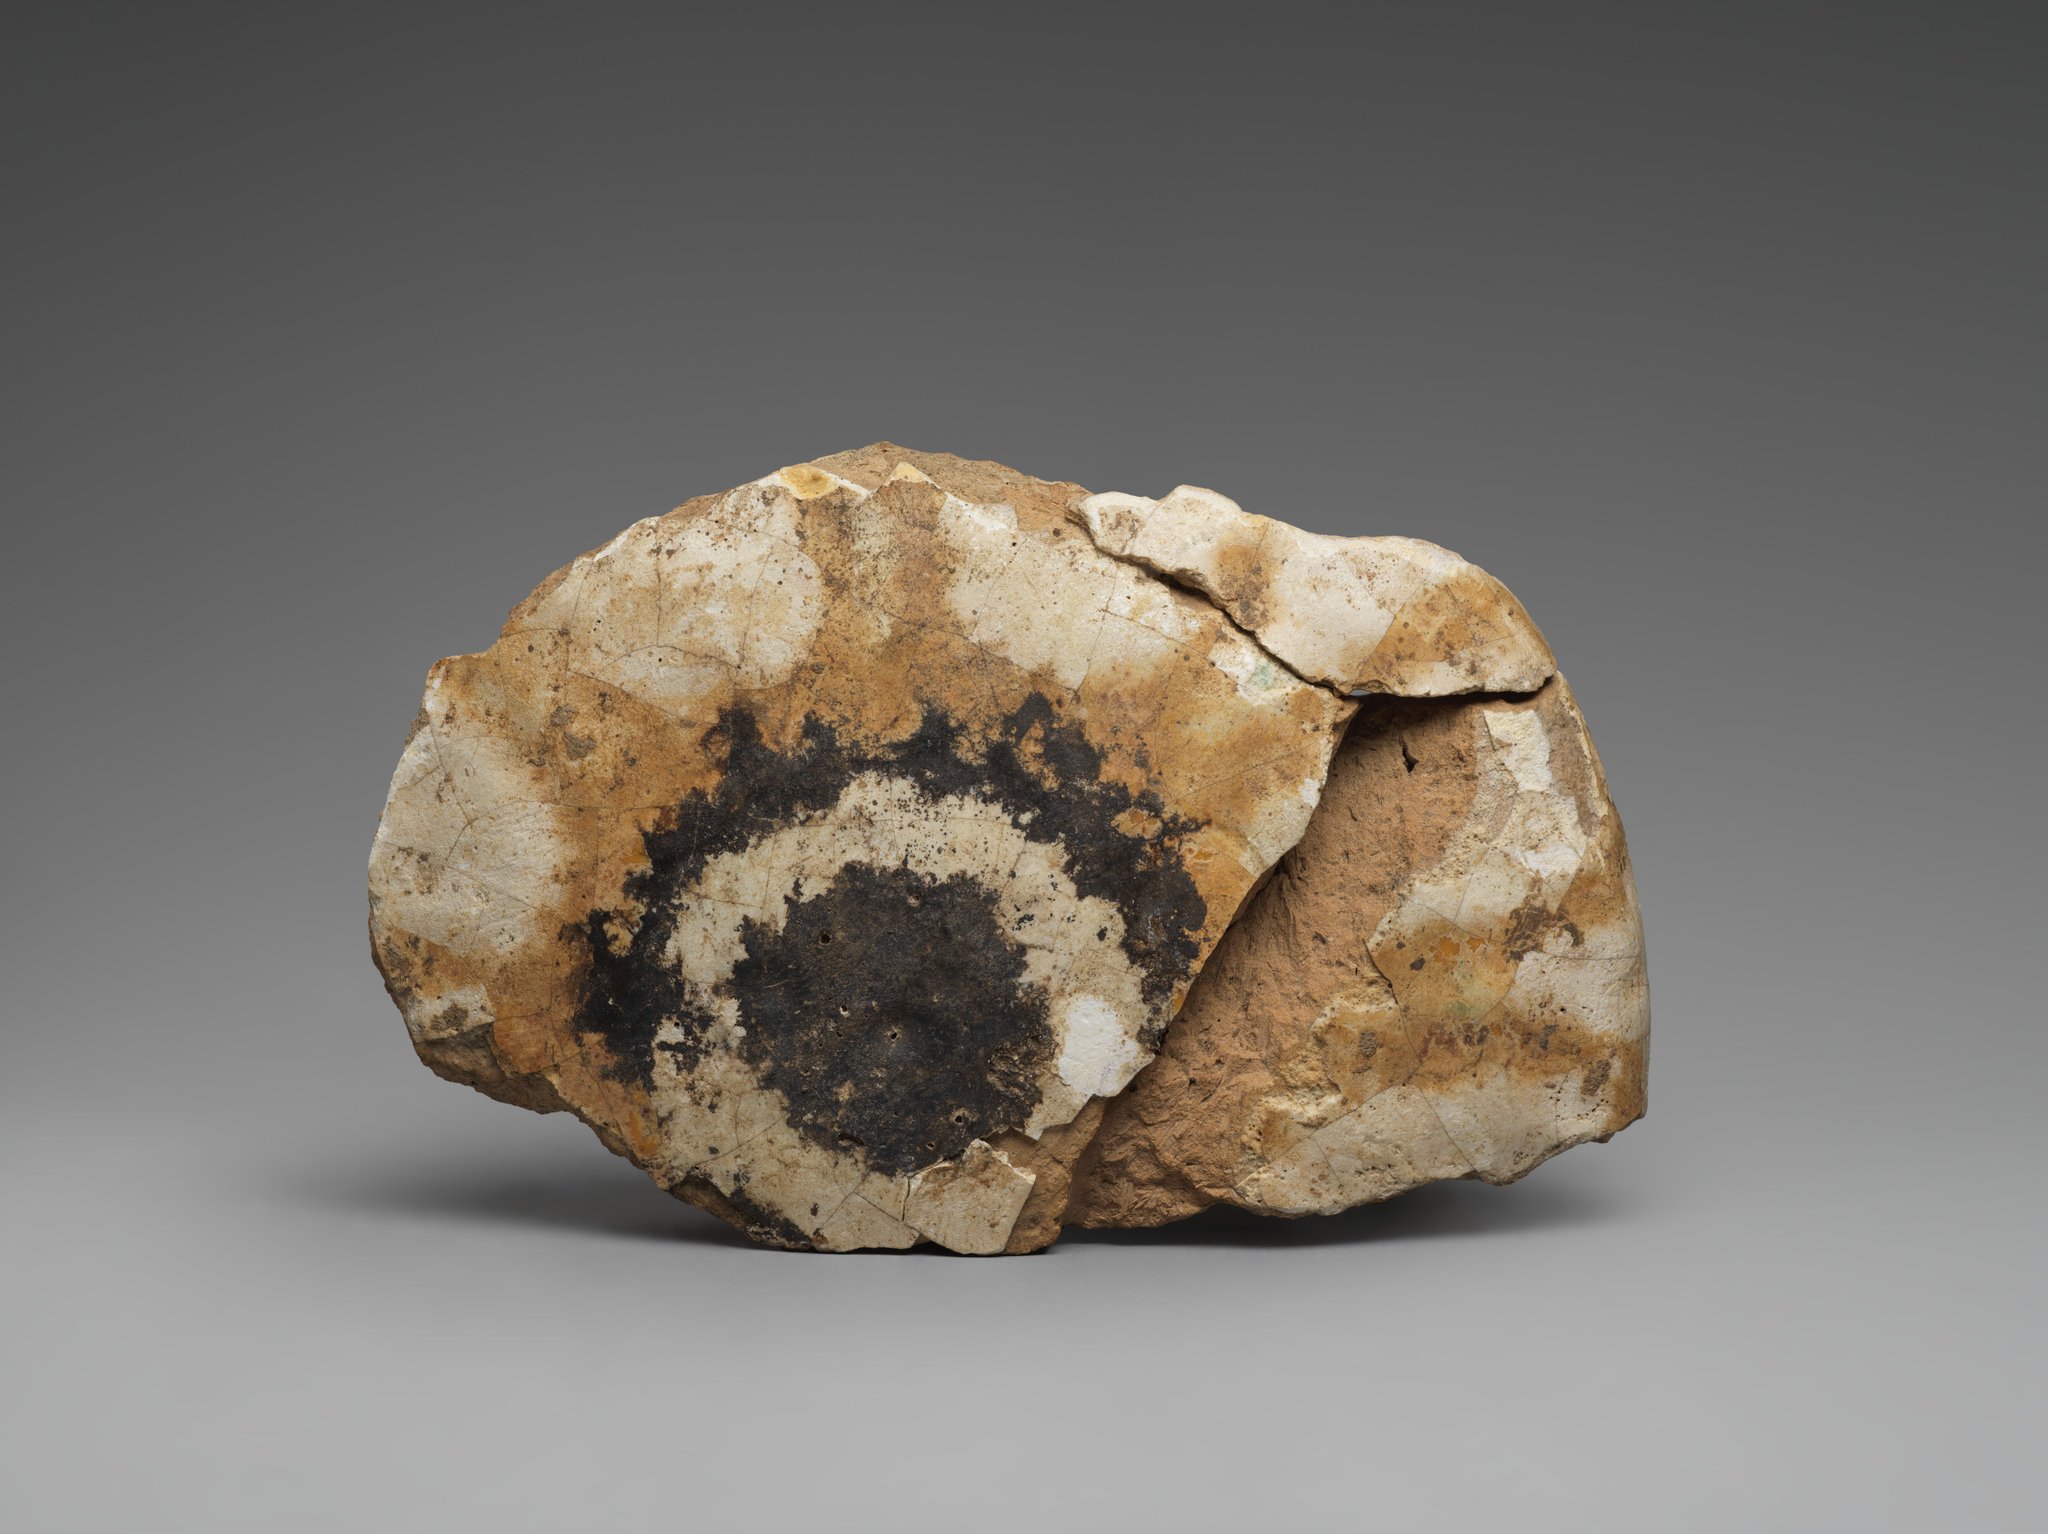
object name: knob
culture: iranian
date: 900-801 BCE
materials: ceramic, glaze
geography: iran